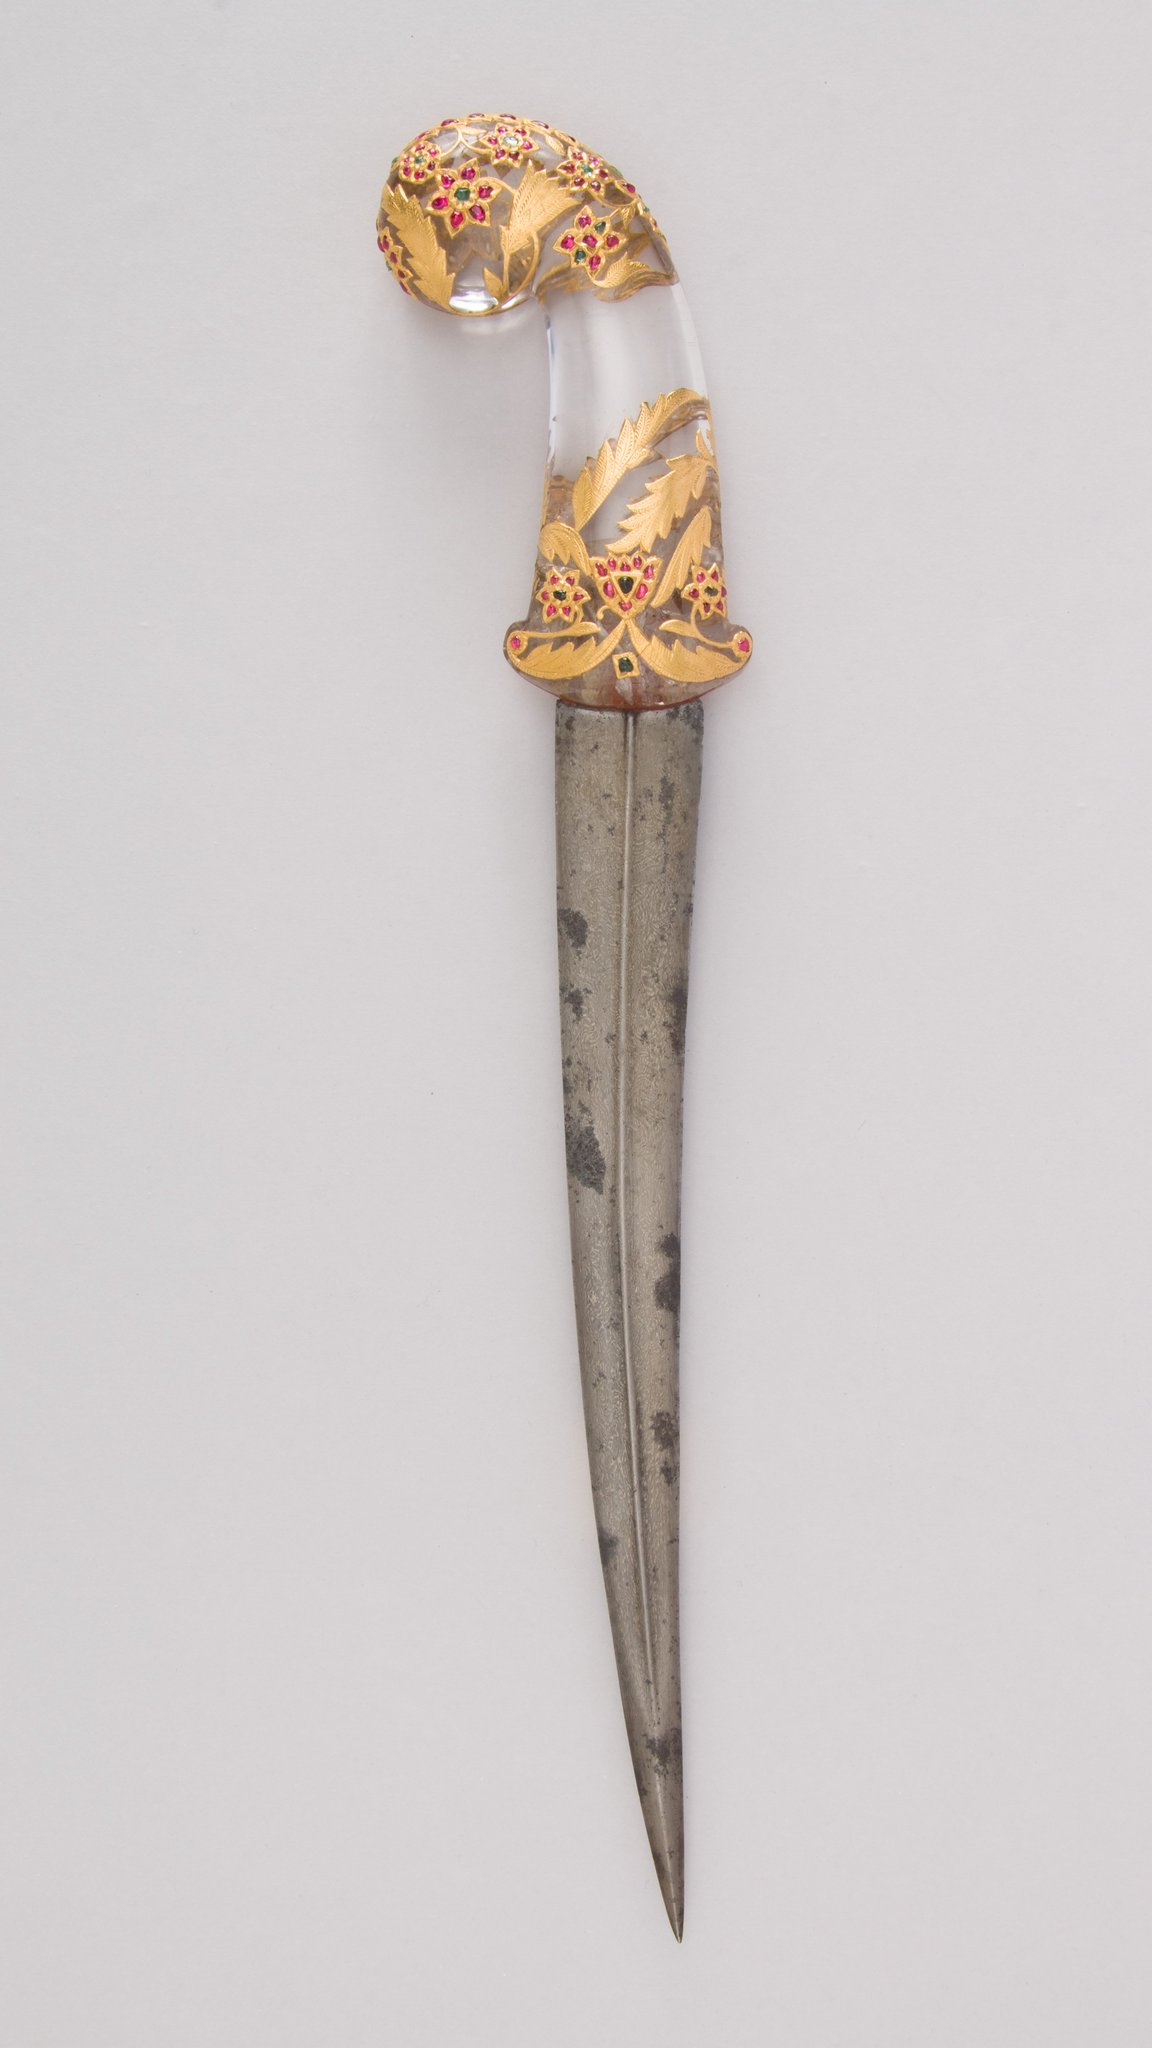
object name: dagger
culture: indian, mughal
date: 1801-1900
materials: gemstone, gold, quartz, steel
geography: india